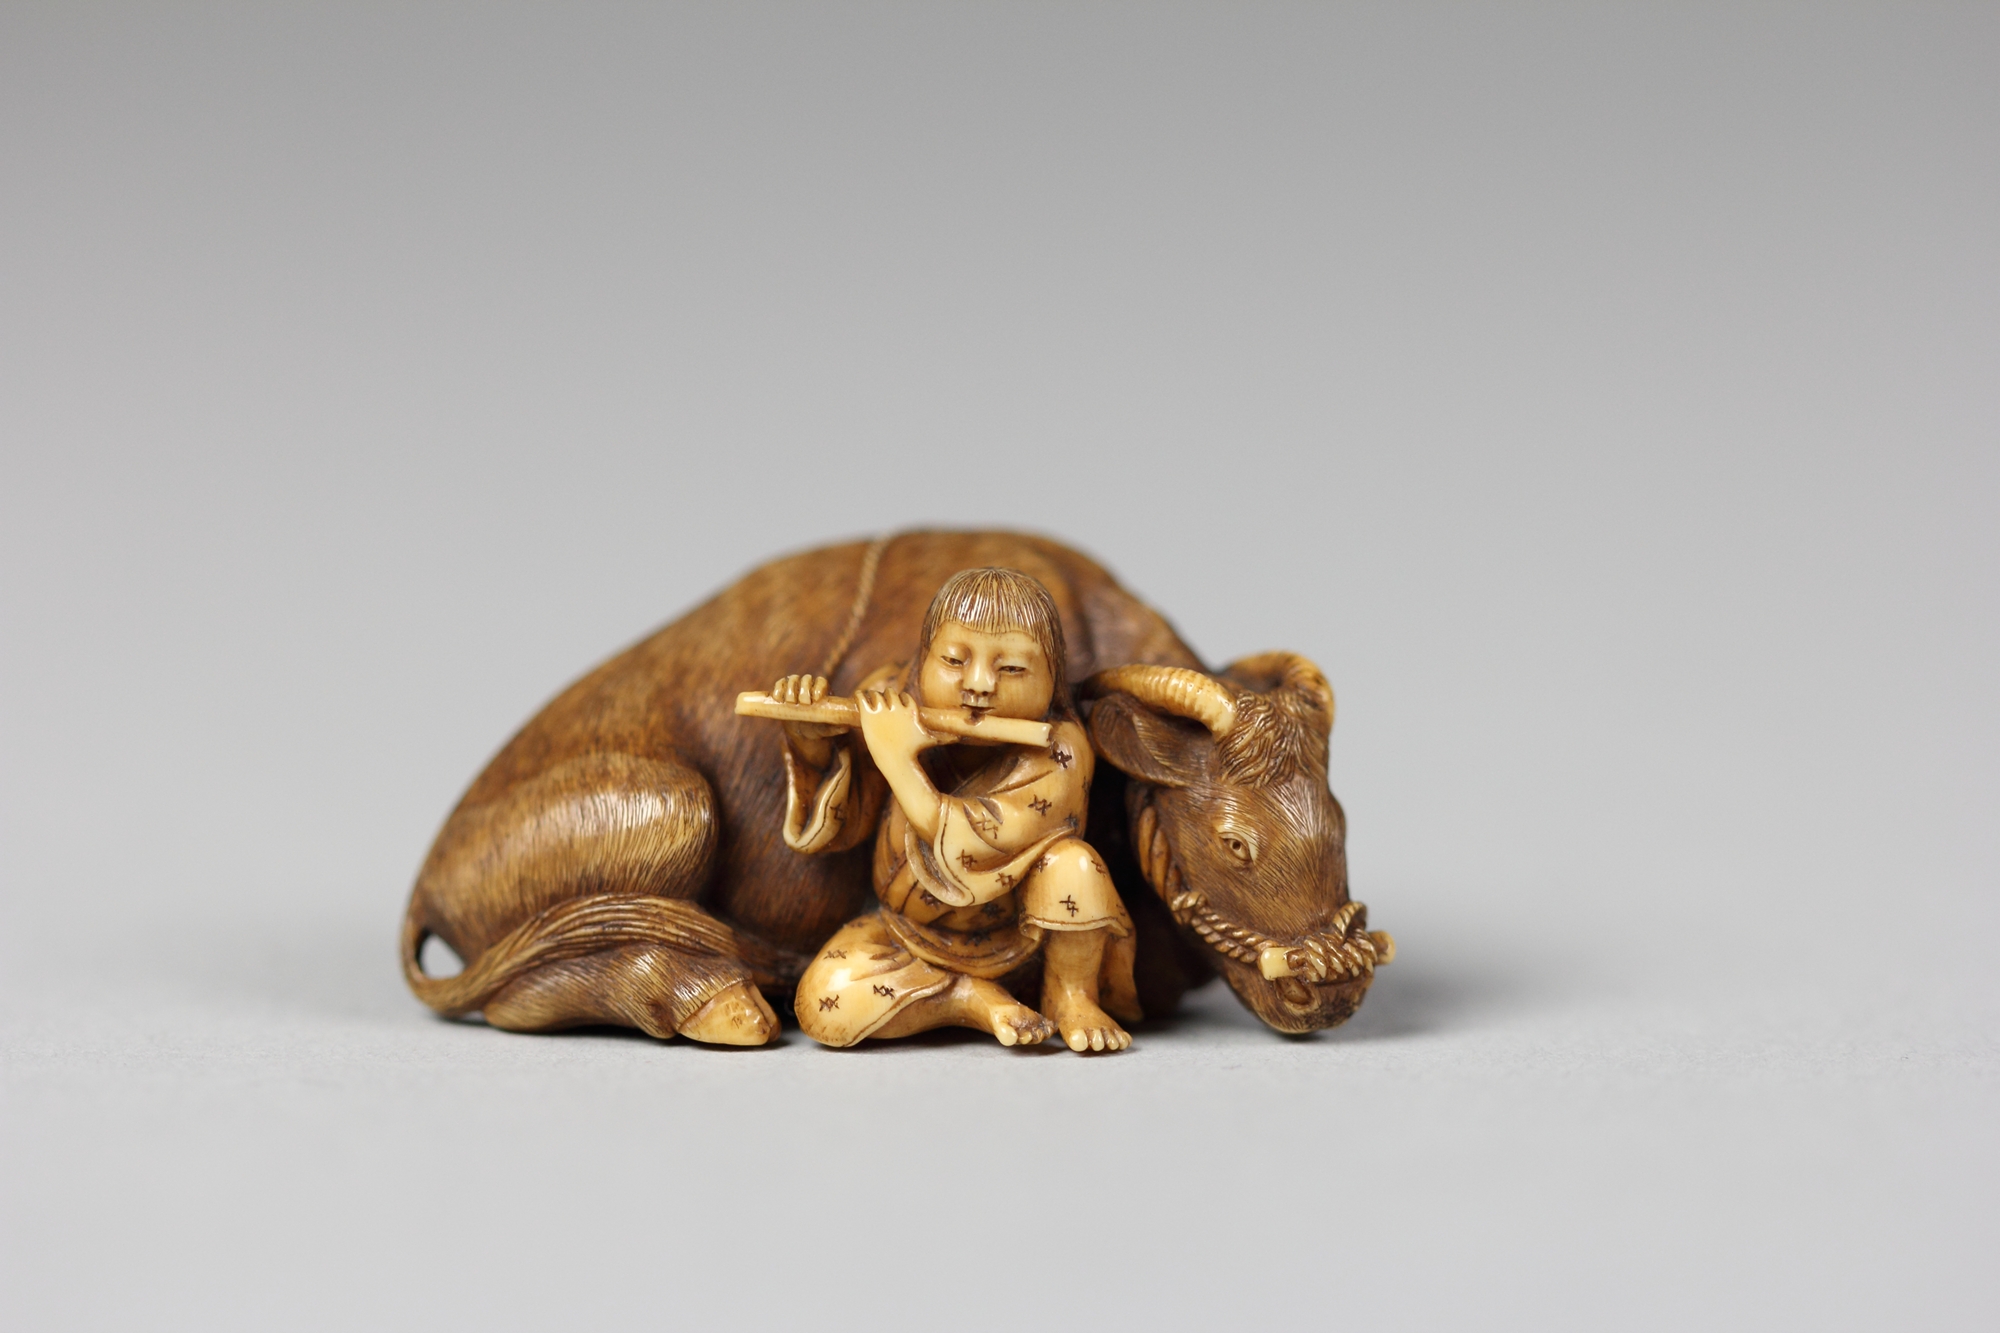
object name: netsuke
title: Netsuke of Ox with Bokudo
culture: japanese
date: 1801-1900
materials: ivory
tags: human figures,flutes